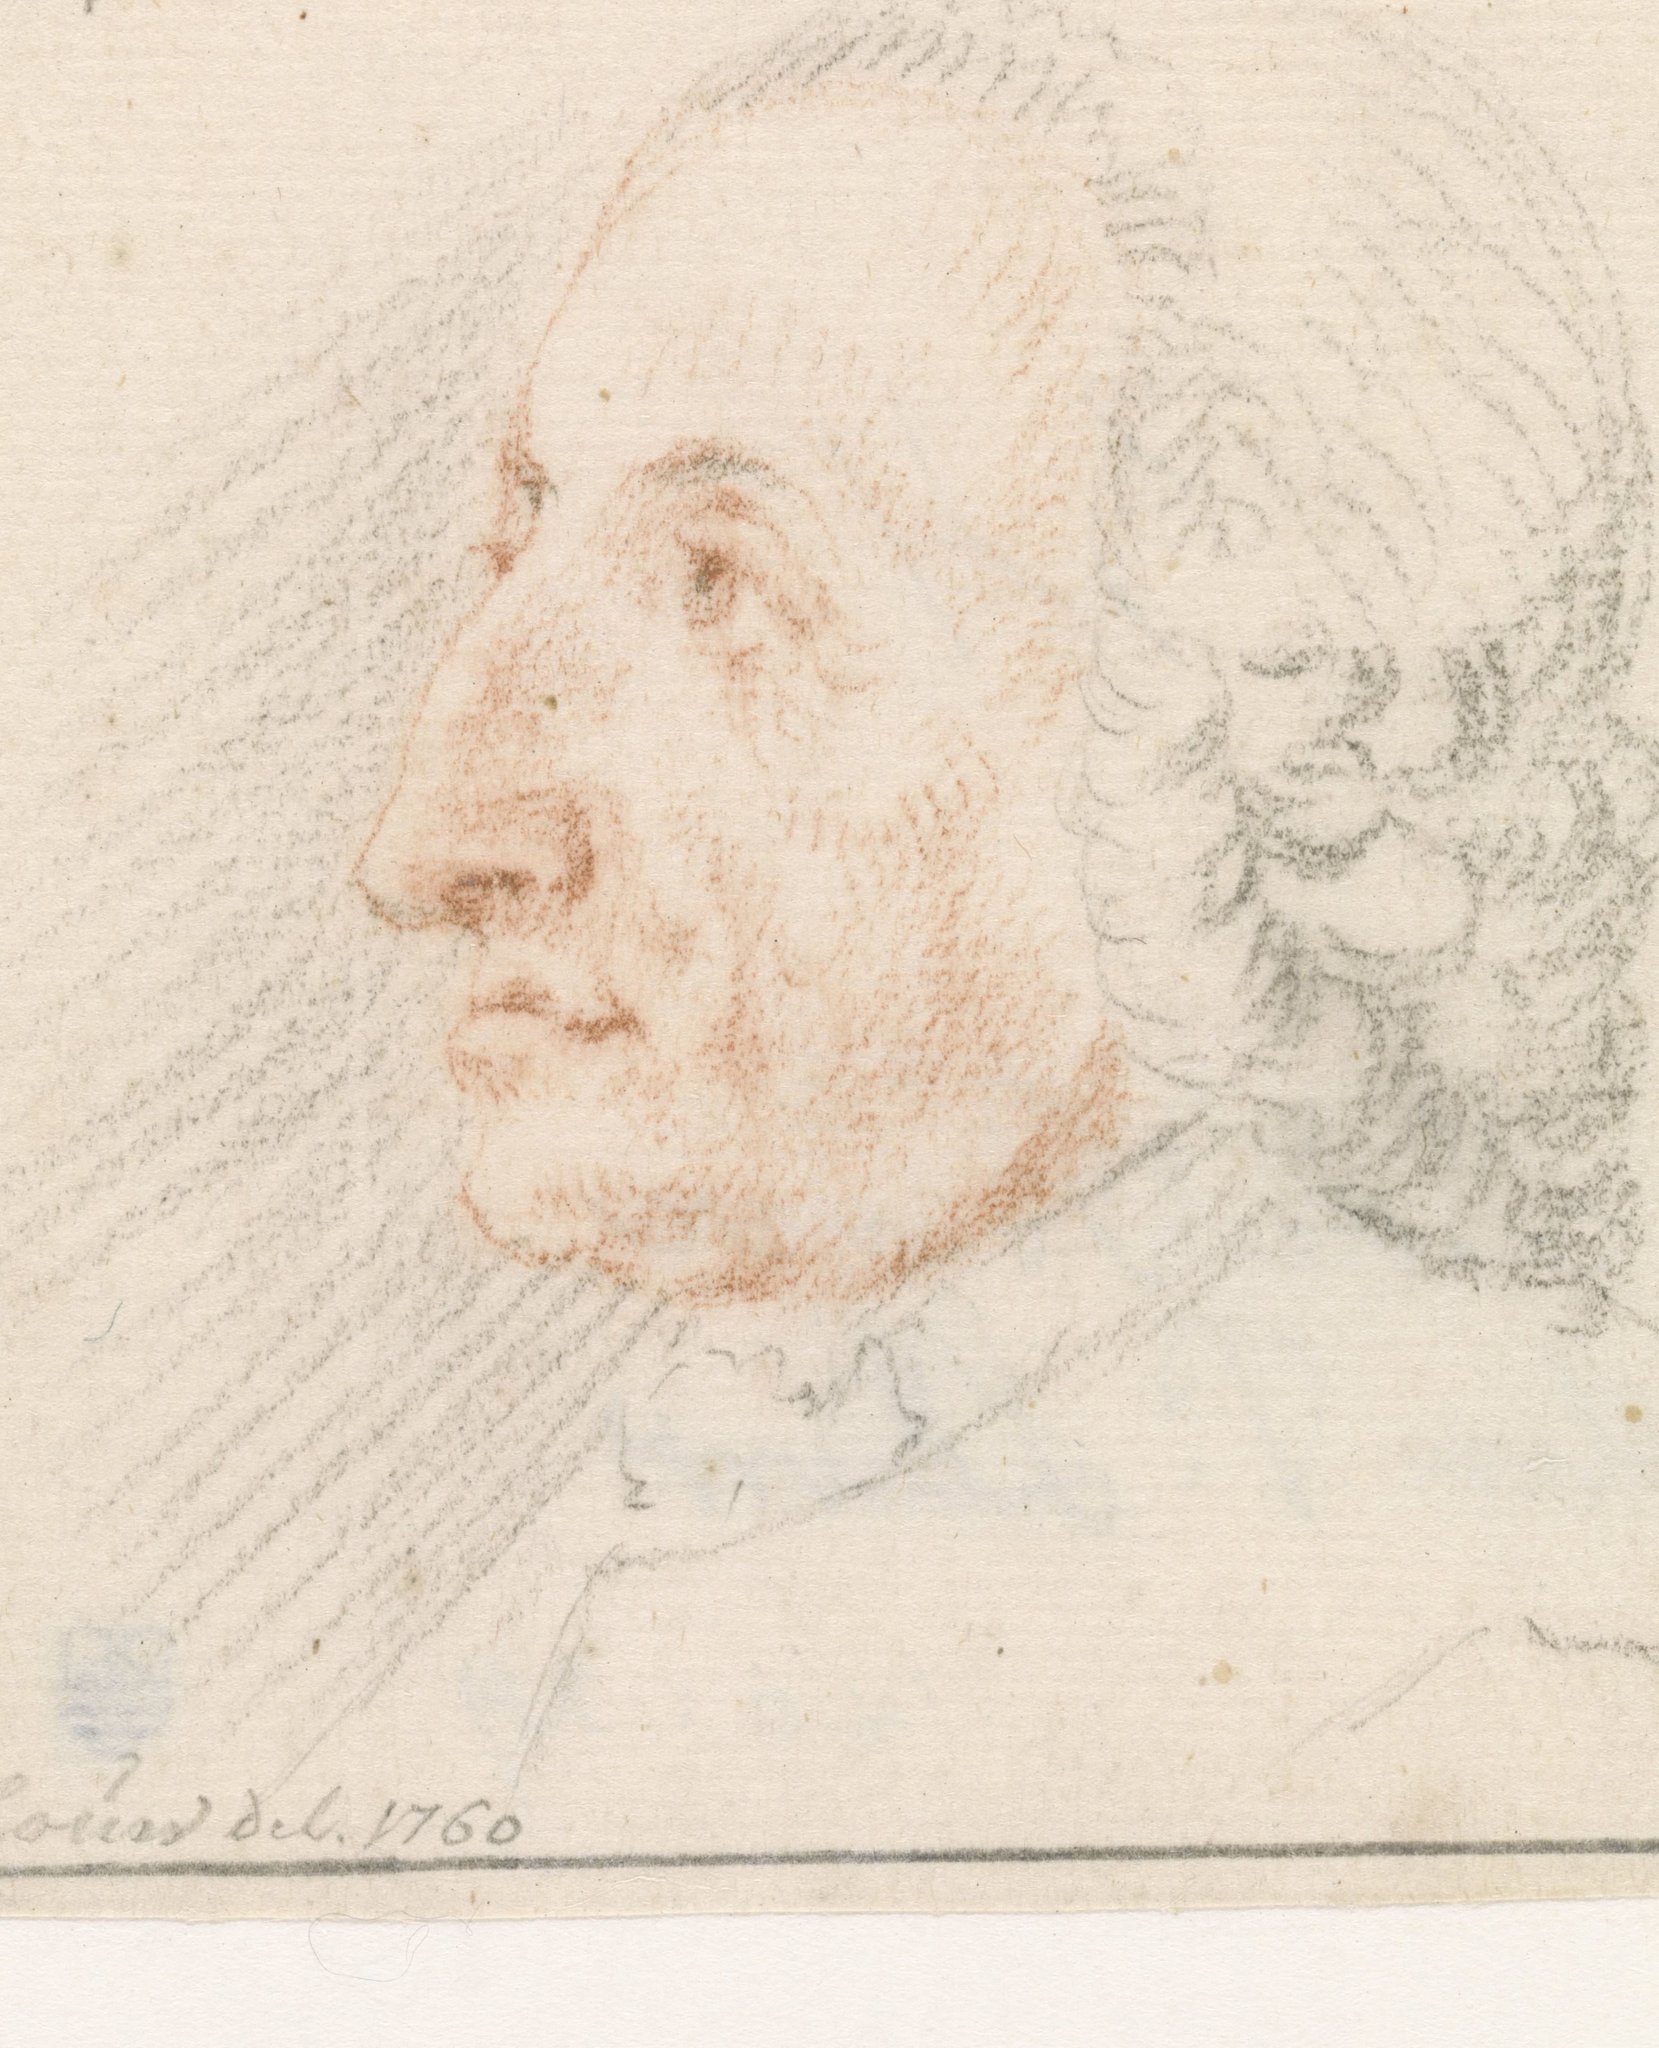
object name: drawing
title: Portret van Jan de Beijer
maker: pieter louw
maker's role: draughtsman, print maker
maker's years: 1725-1800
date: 1760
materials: chalk, paper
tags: jan de beijer, historical persons, portrait, self-portrait of painter, portrait, self-portrait of artist, portrait, self-portrait of draughtsman